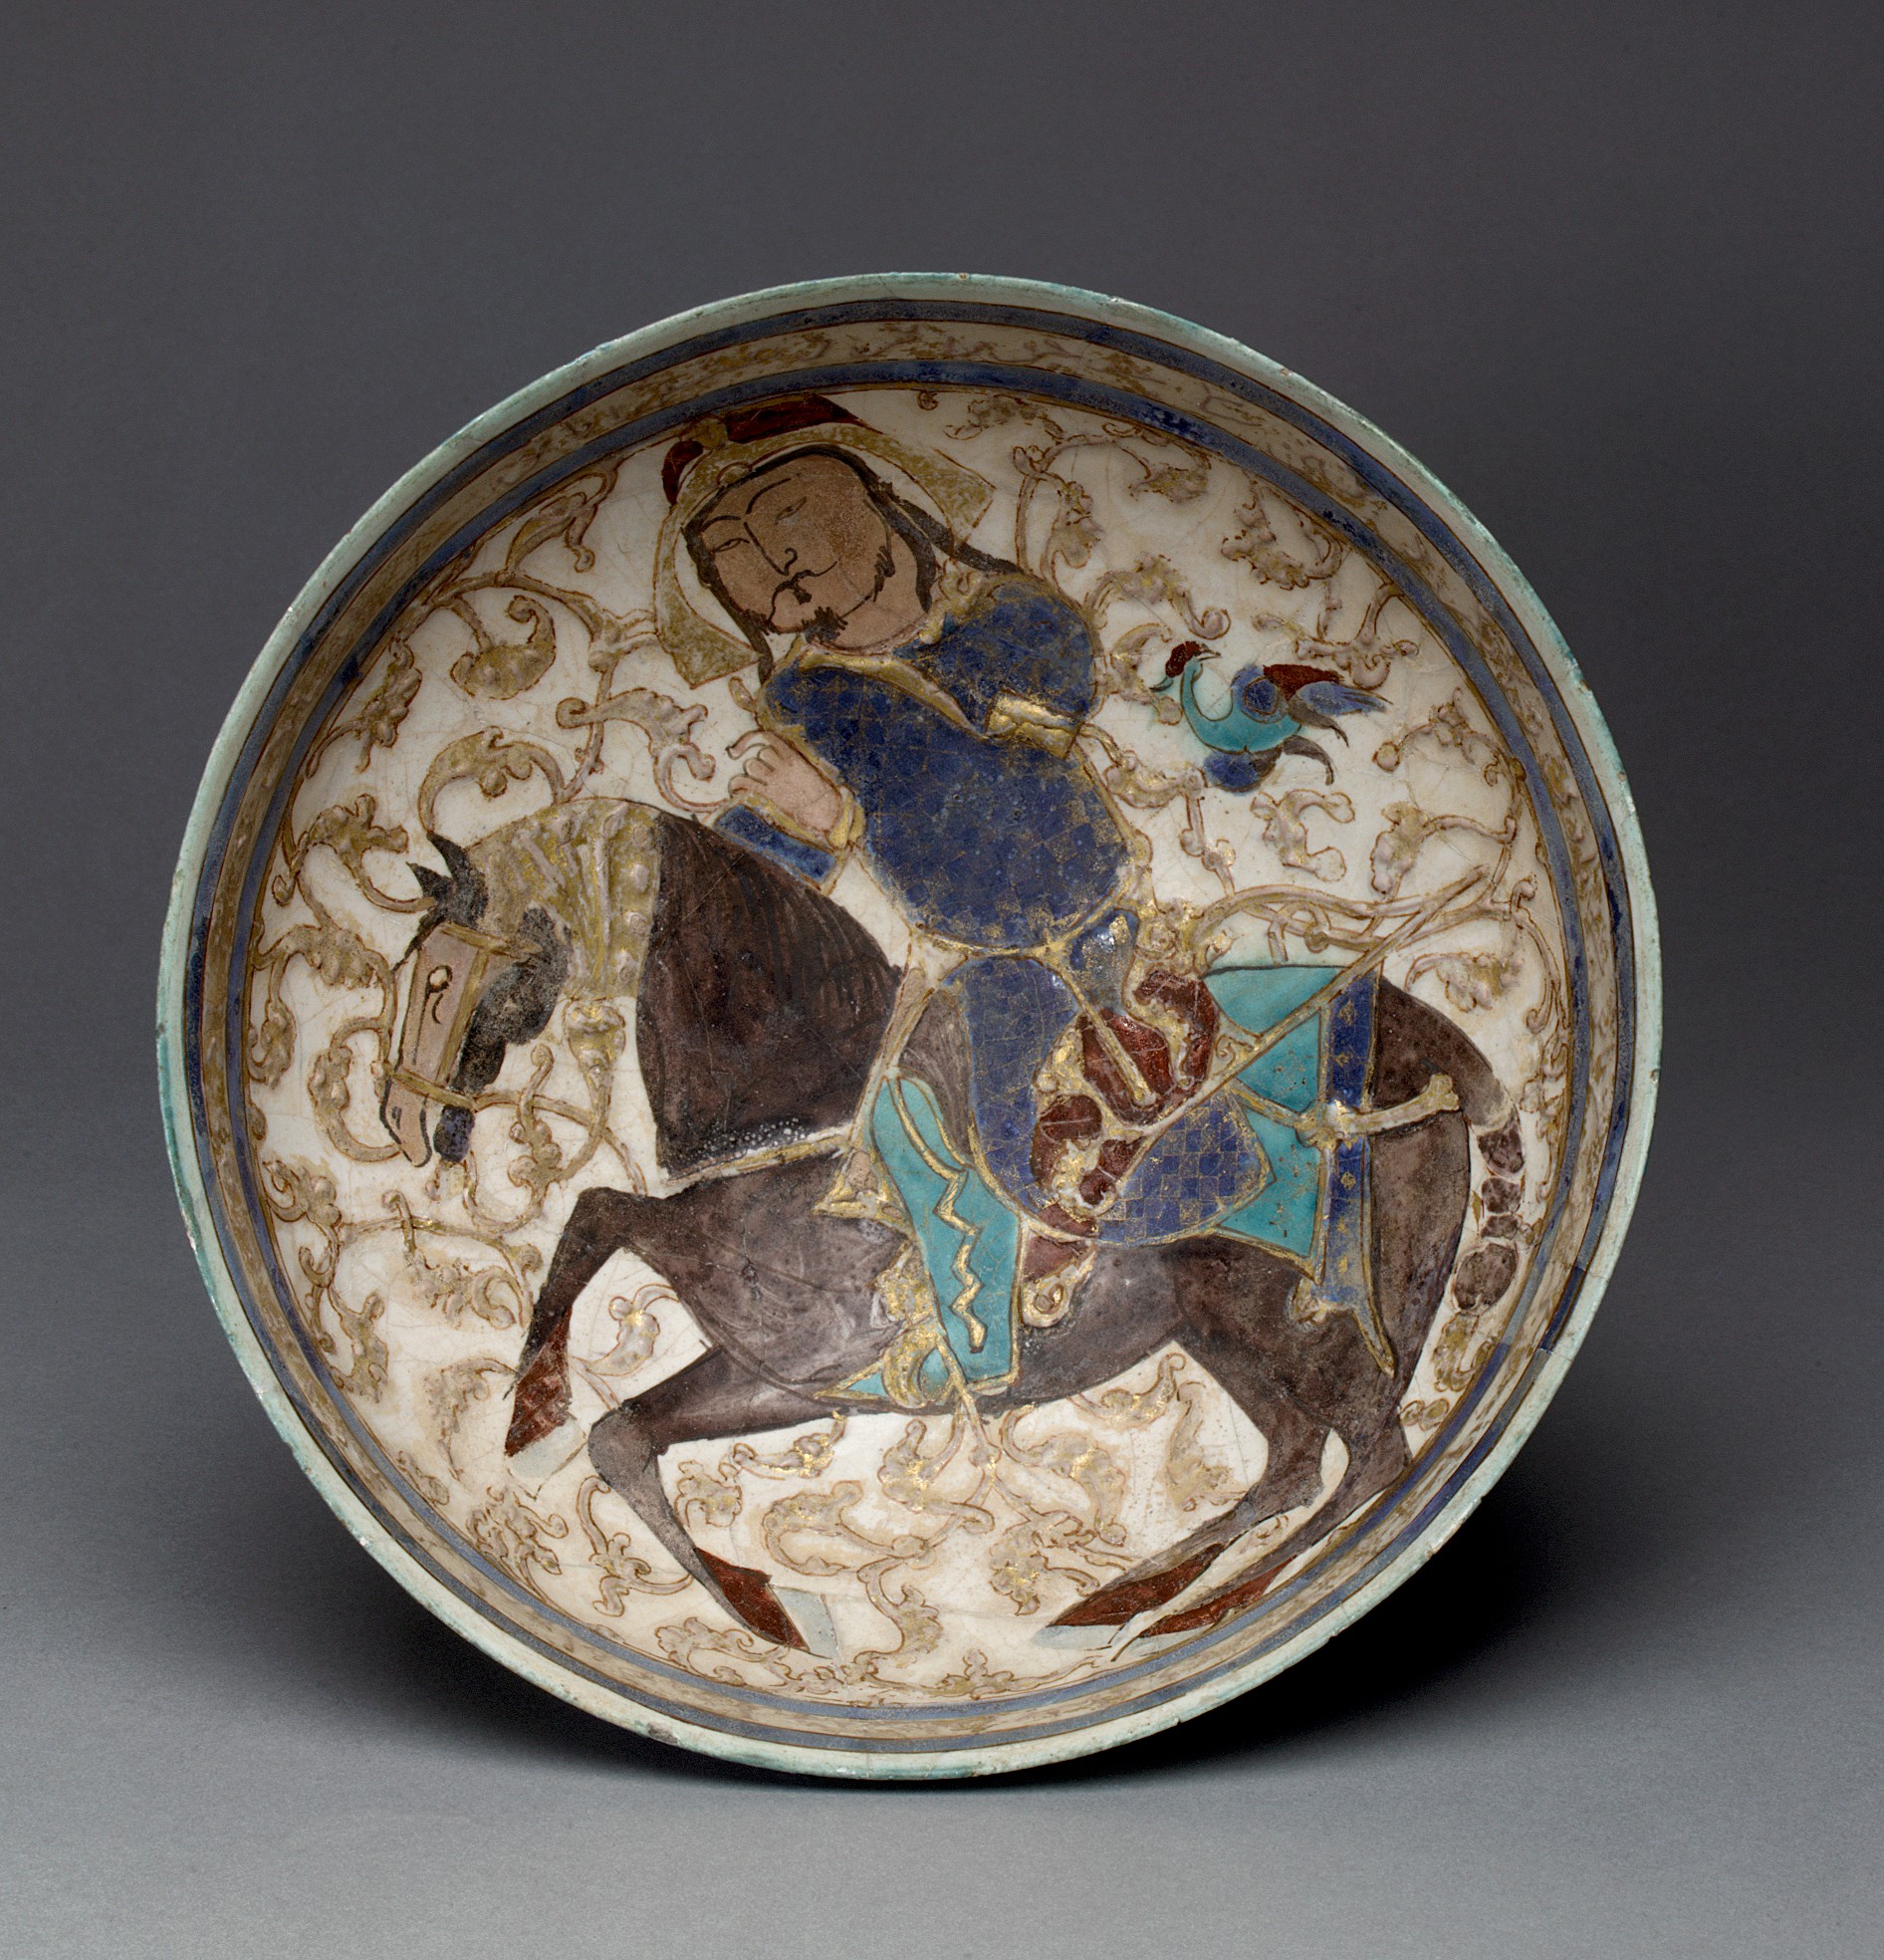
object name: bowl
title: Bowl with Prince on Horseback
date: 1101-1300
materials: glaze, stonepaste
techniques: gilding, overglaze, painting, polychrome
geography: iran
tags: men,horses